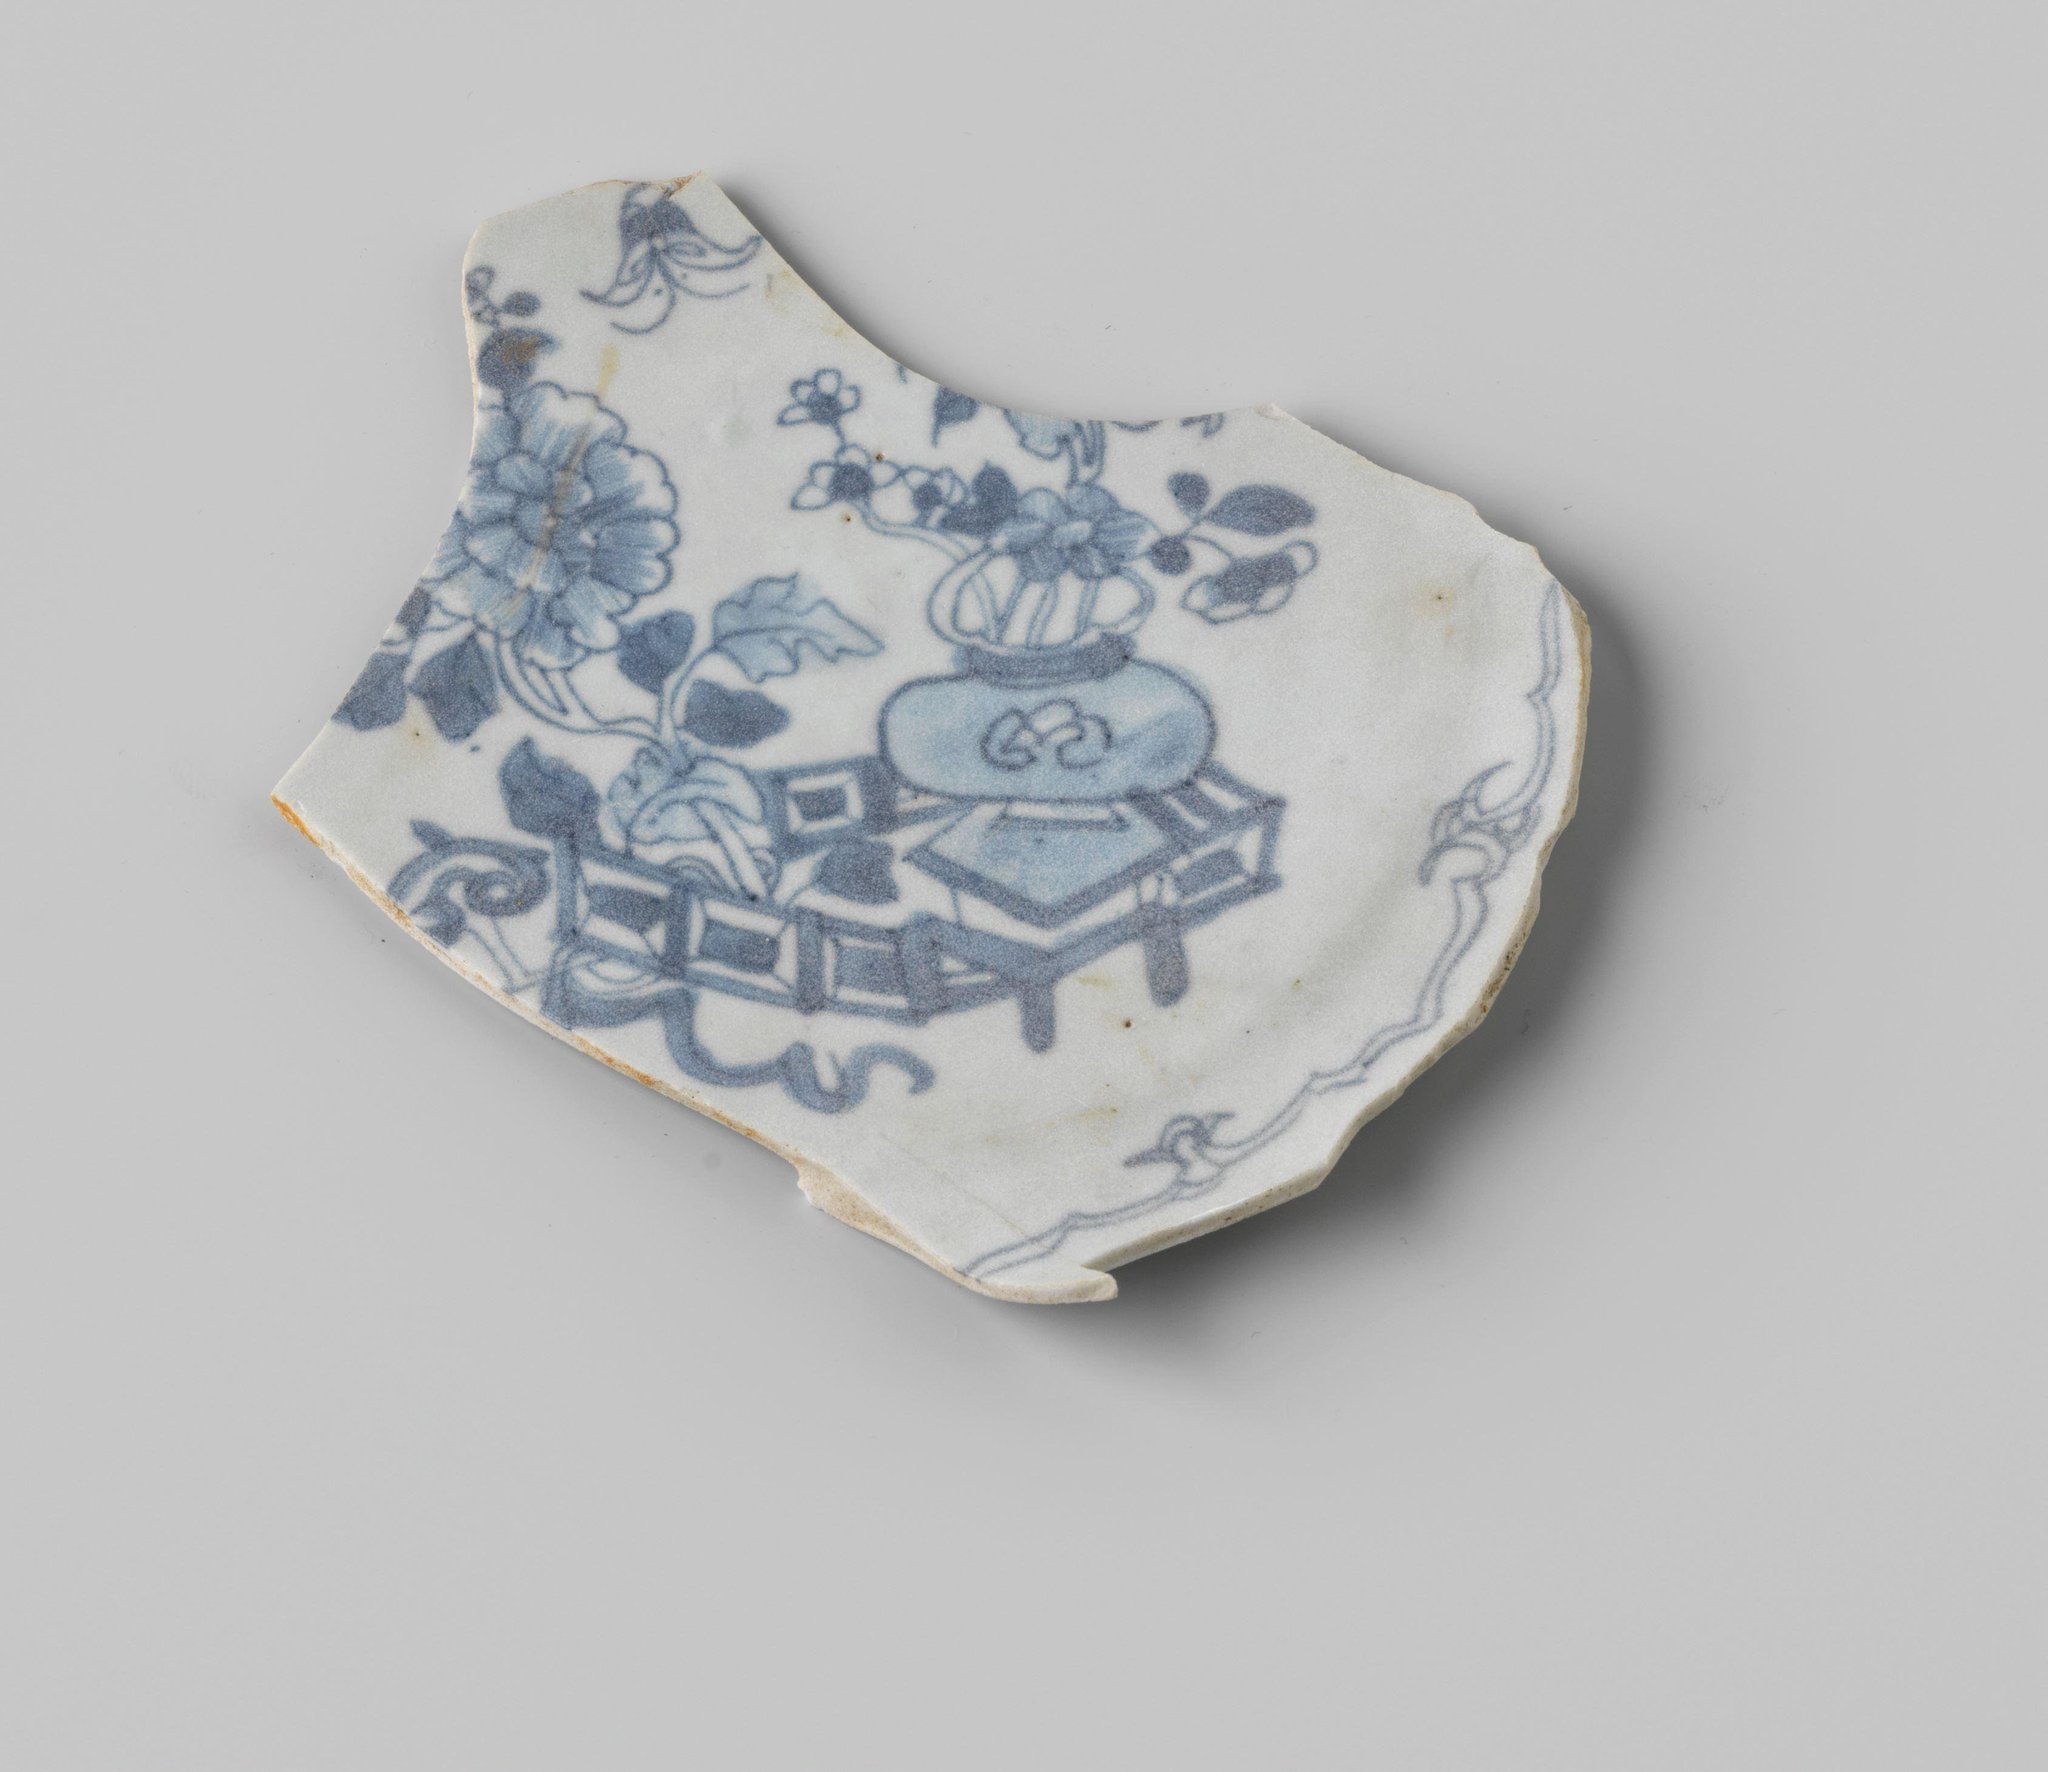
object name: plate dish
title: Bord, gevonden bij V.O.C.-schip Witte Leeuw, mogelijk afkomstig van Zeelelie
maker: Anonymous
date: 1725-1800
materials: porcelain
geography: jingdezhen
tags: verenigde oostindische compagnie, sint-helena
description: Later blue and white Chinese porcelain with flower patterns. Part of a base and cavetto of a plate. A white body and pale blue painting under a greenish white translucent glaze. A central decoration of a table with a flower vase. To the left a peony branch, surrounded by a double band, with accolades, intersected by stylized buds.